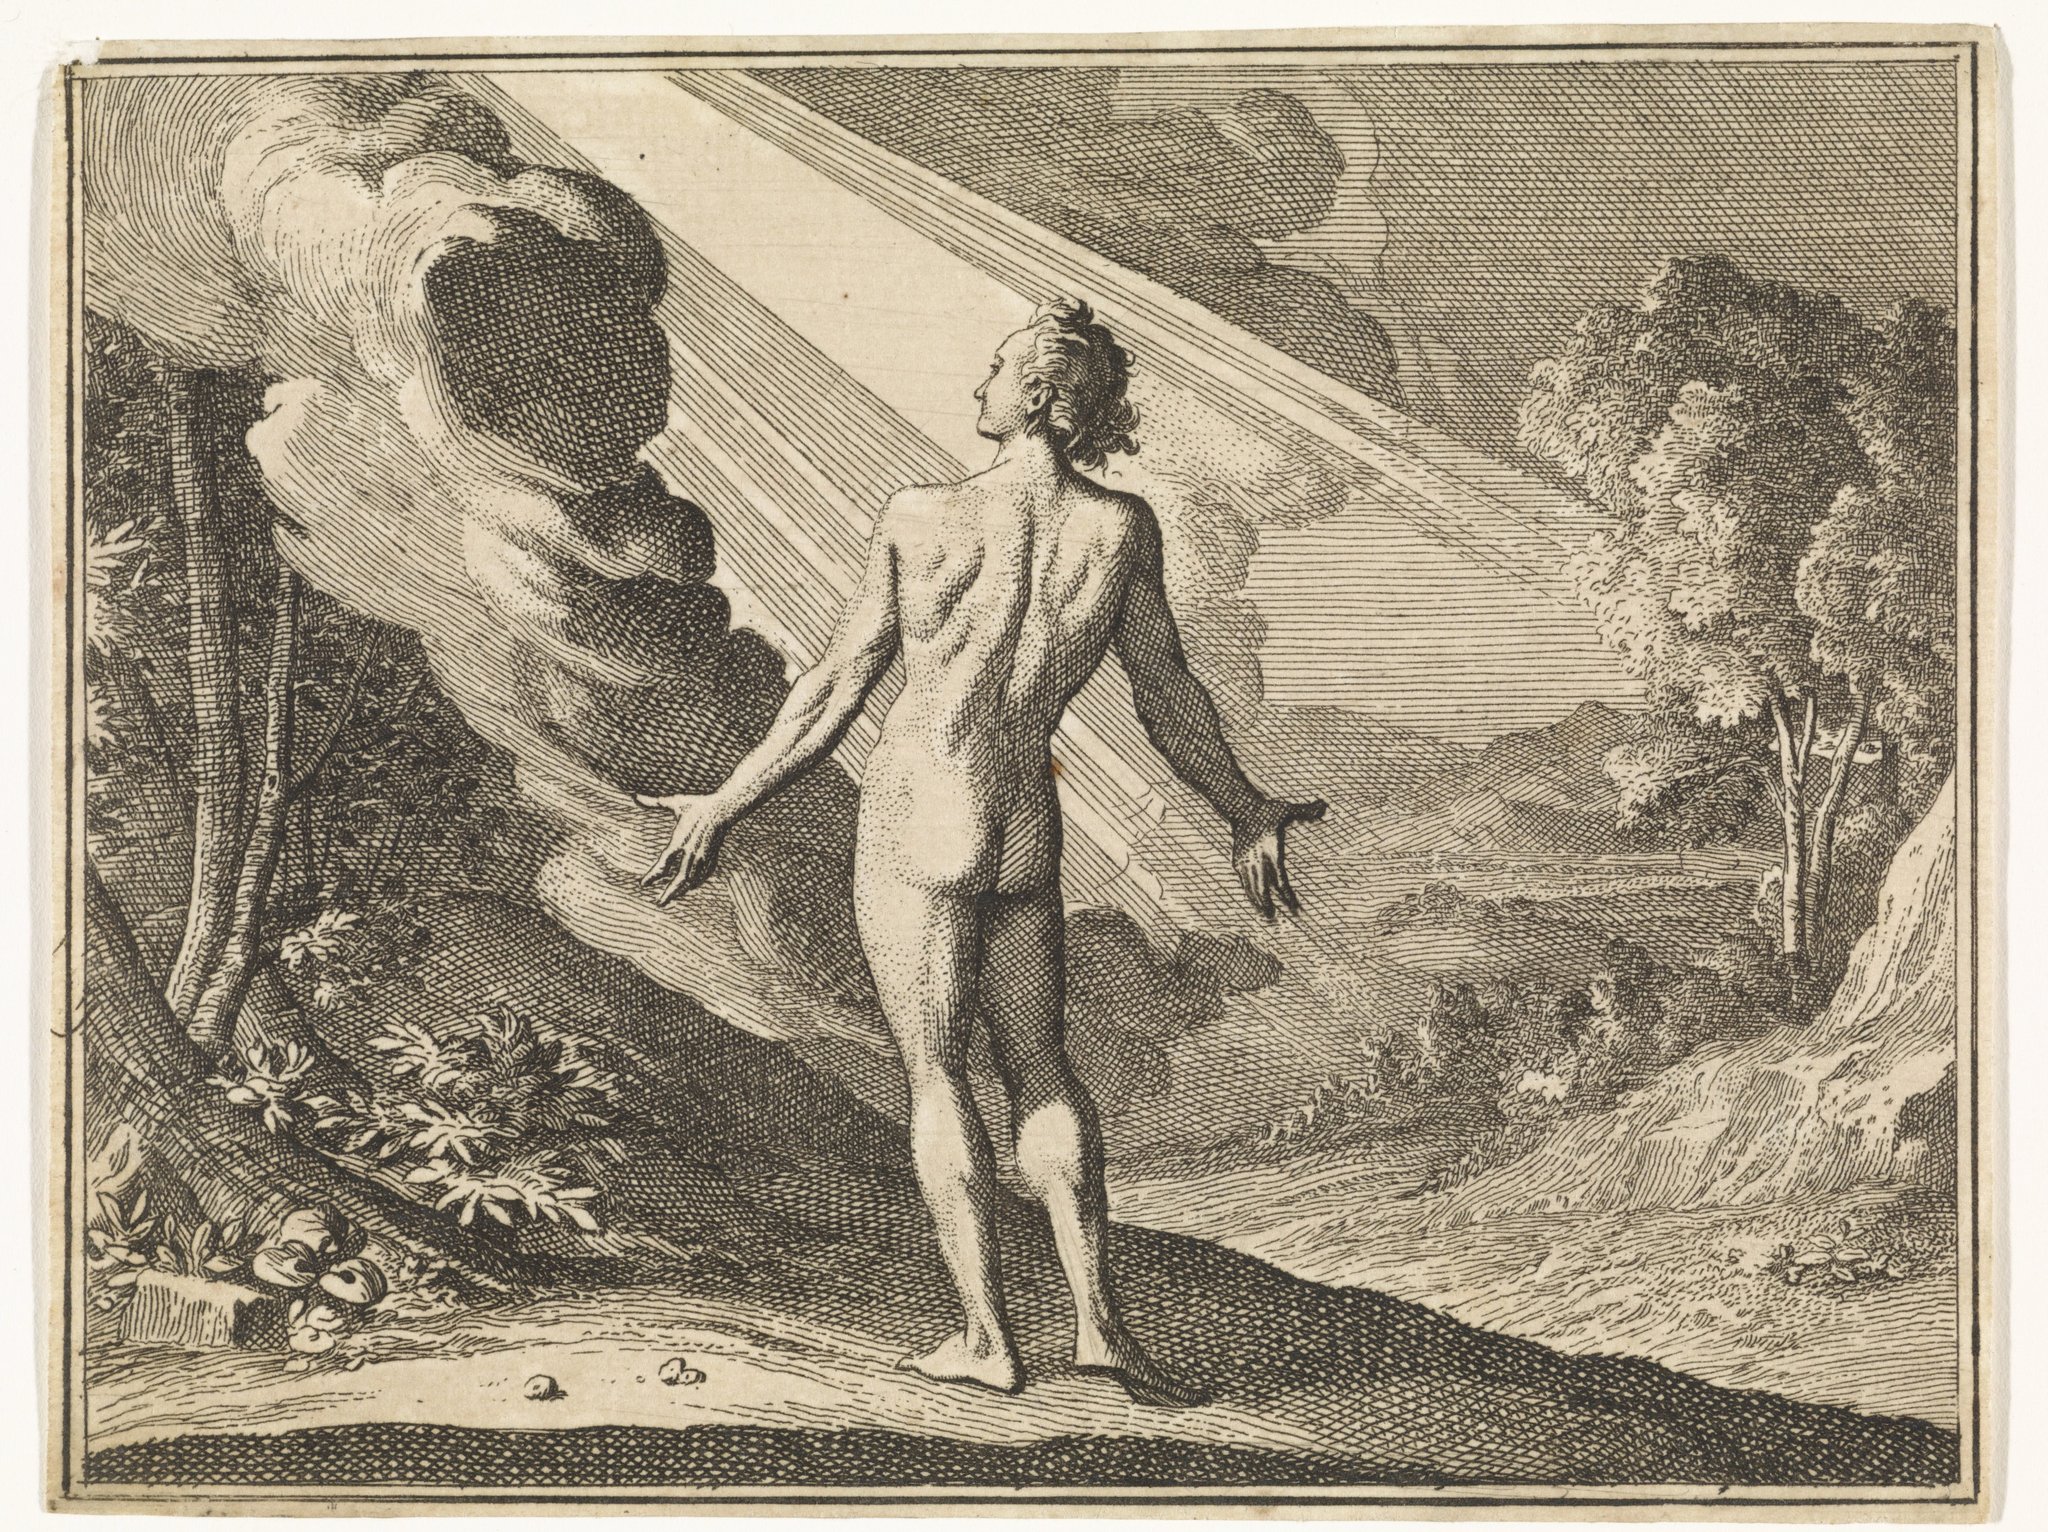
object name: print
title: Adam in het paradijs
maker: caspar luyken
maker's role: draughtsman, print maker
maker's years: 1672-1708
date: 1712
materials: paper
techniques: etching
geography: amsterdam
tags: adam in the garden of eden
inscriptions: number: ‘2’, collector's mark: Lugt 2228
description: Illustratie uit: Luyken, Jan. De schriftuurlyke geschiedenissen en gelykenissen van het Oude en Nieuwe Verbond, 2 delen. Amsterdam: Wed. Pieter Arentsz II en Cornelis van der Sys, 1712, dl. I.